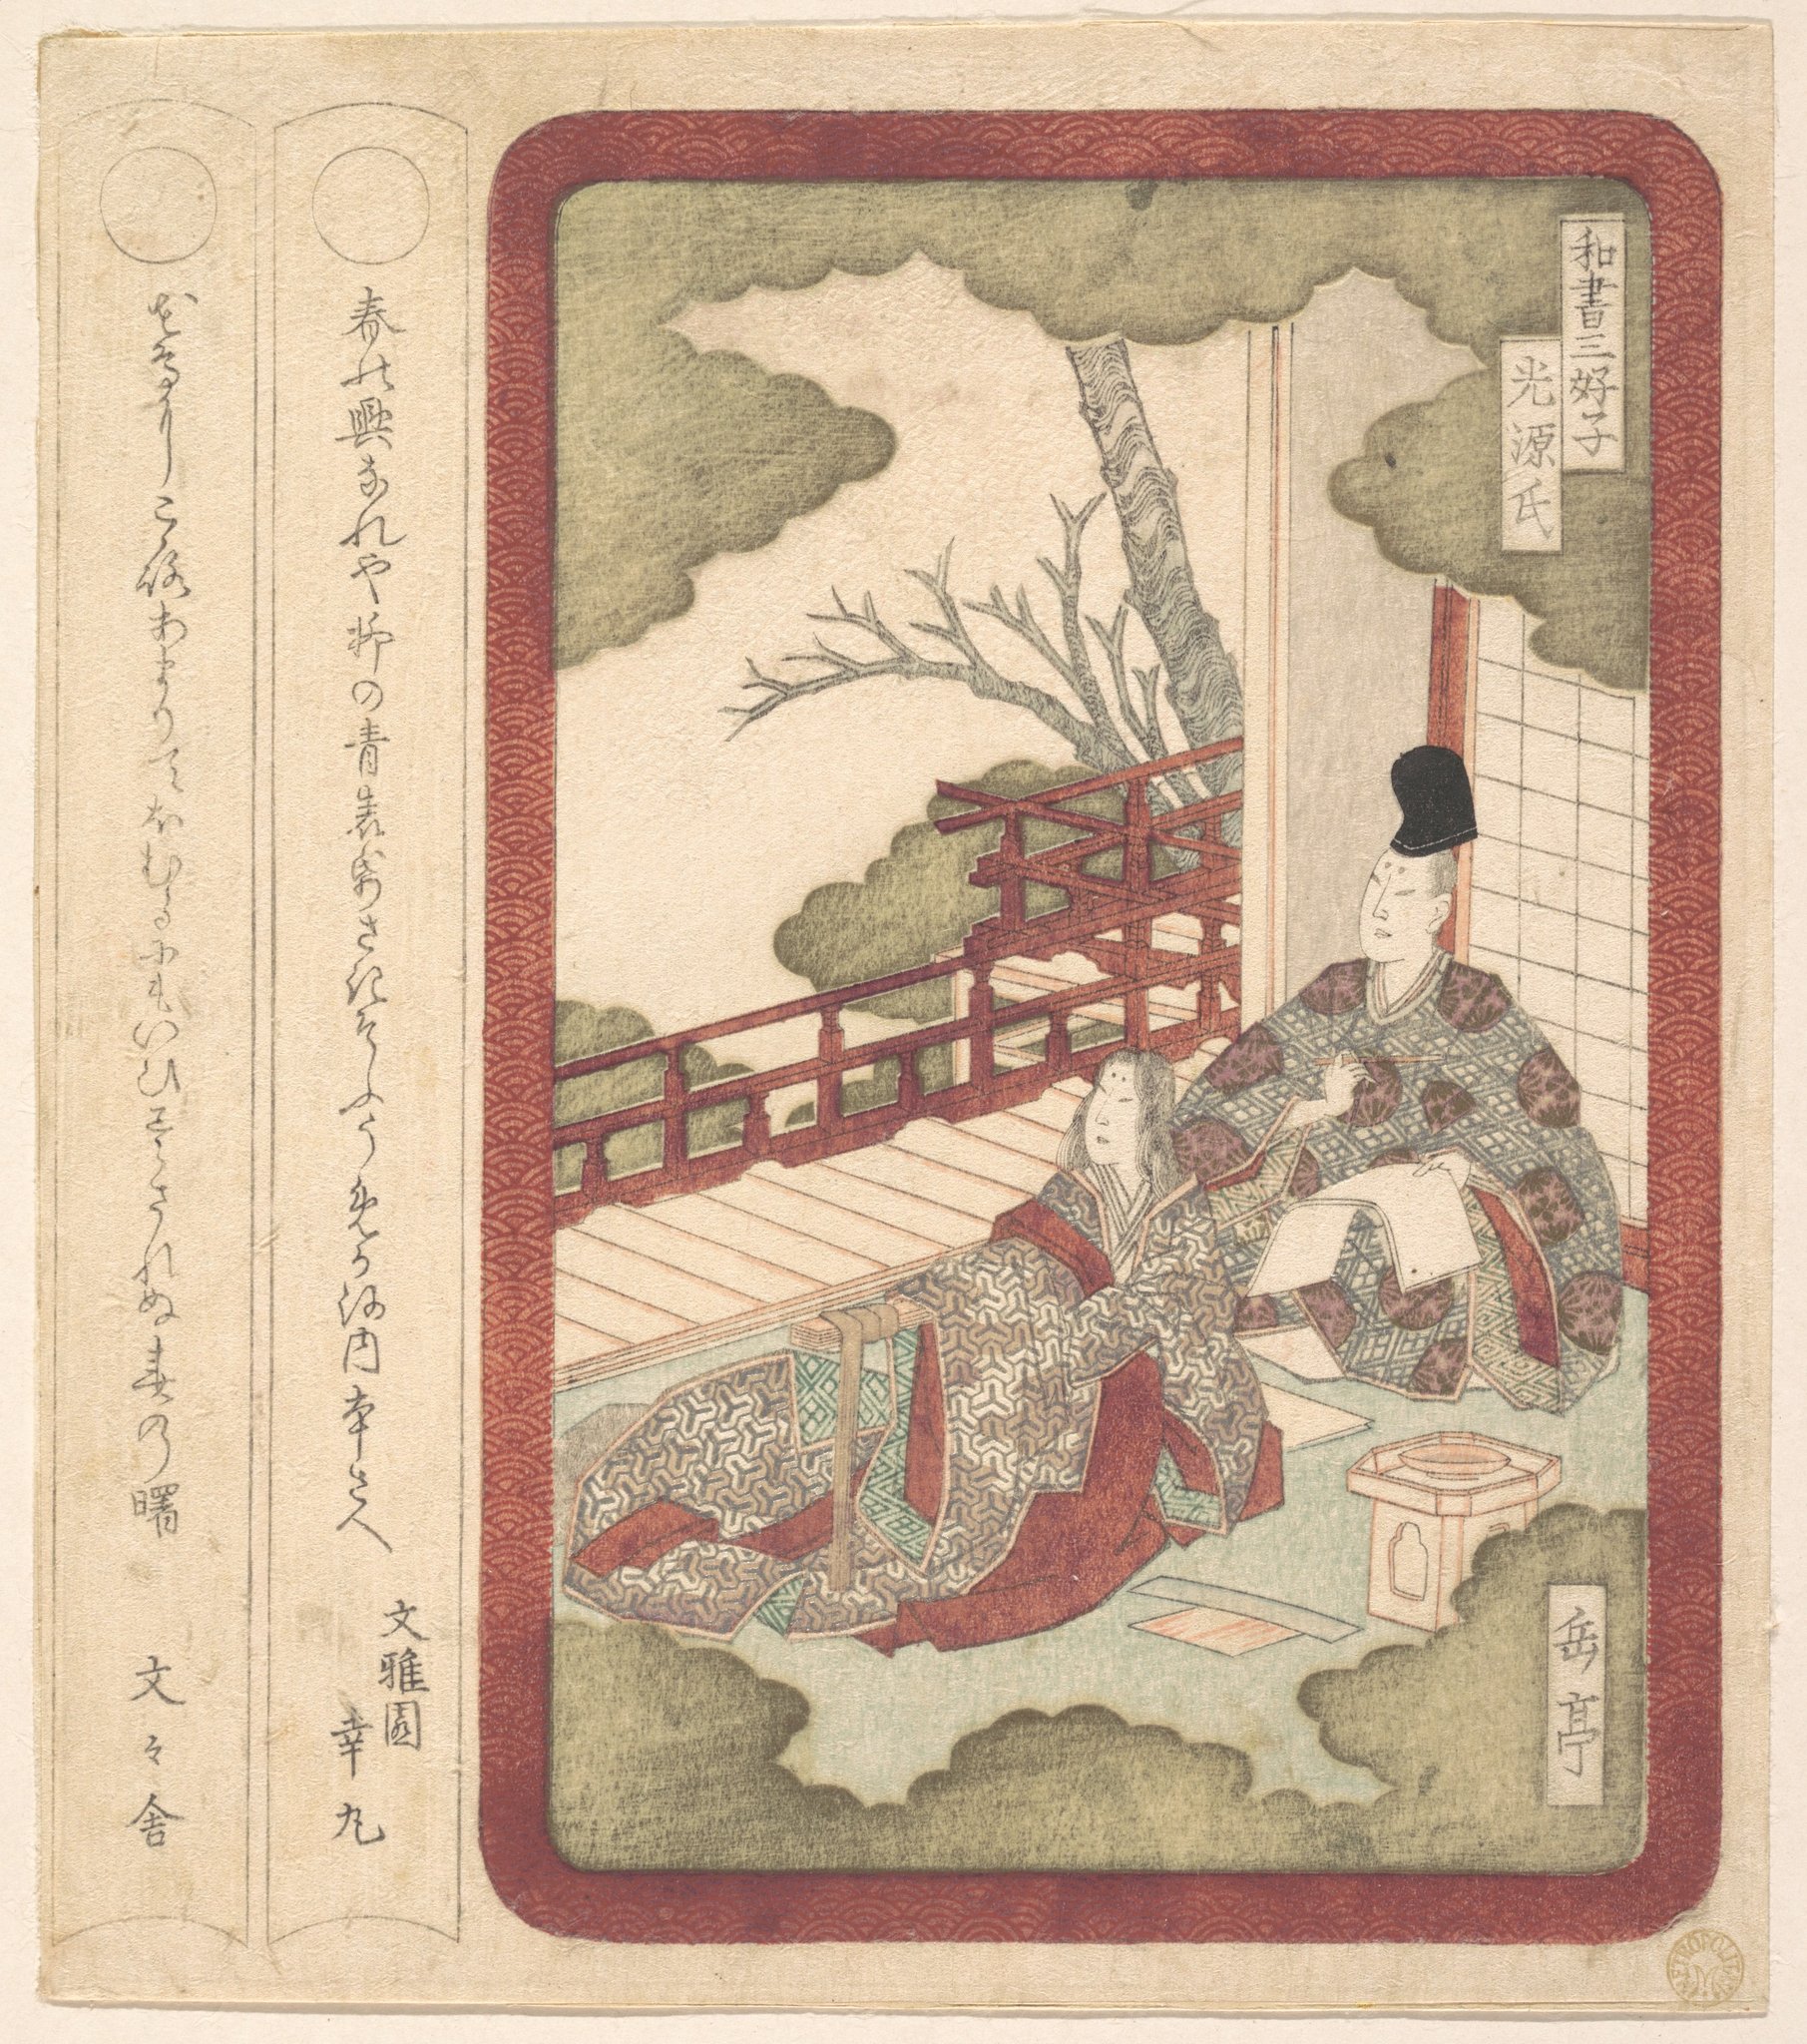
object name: print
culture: japanese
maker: yashima gakutei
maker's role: artist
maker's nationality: japanese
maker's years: 1786-1868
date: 1820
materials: ink, paper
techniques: surimono, woodblock print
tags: women,trees